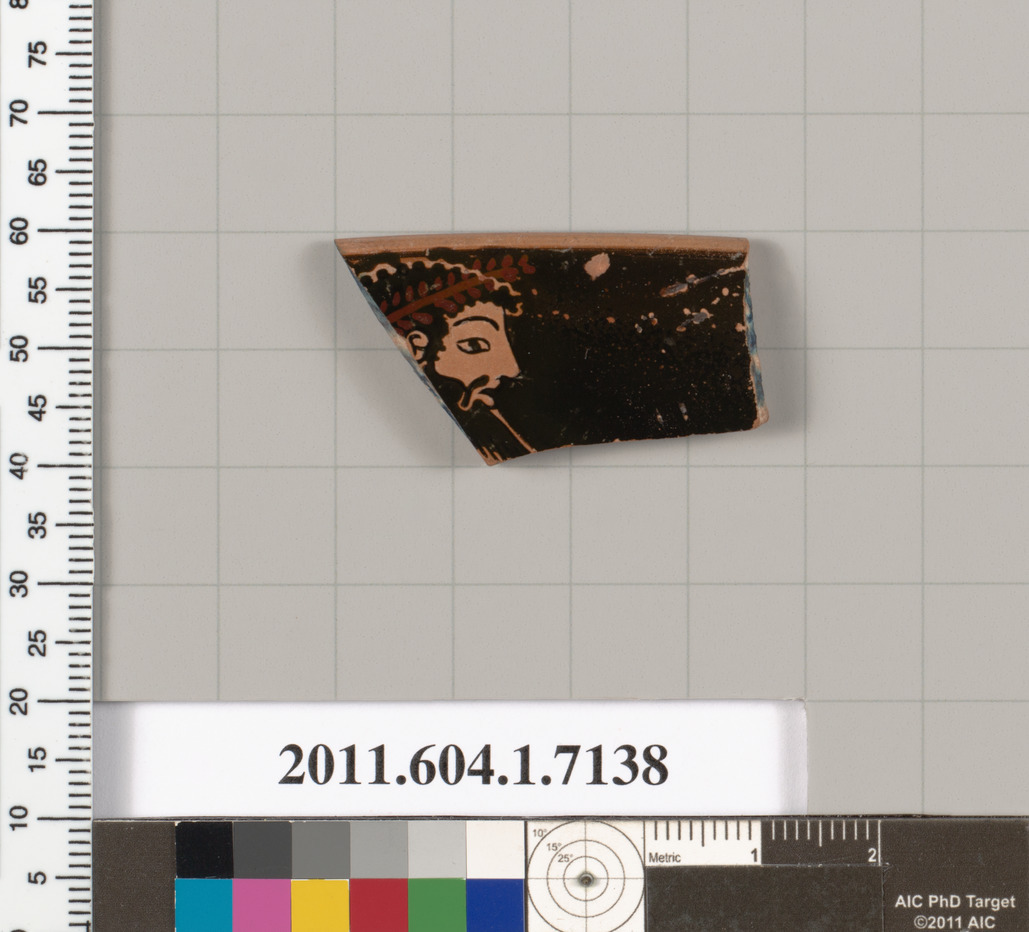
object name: kylix fragment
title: Terracotta rim fragment of a kylix (drinking cup)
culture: greek, attic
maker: makron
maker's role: artist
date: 500-480 BCE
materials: terracotta